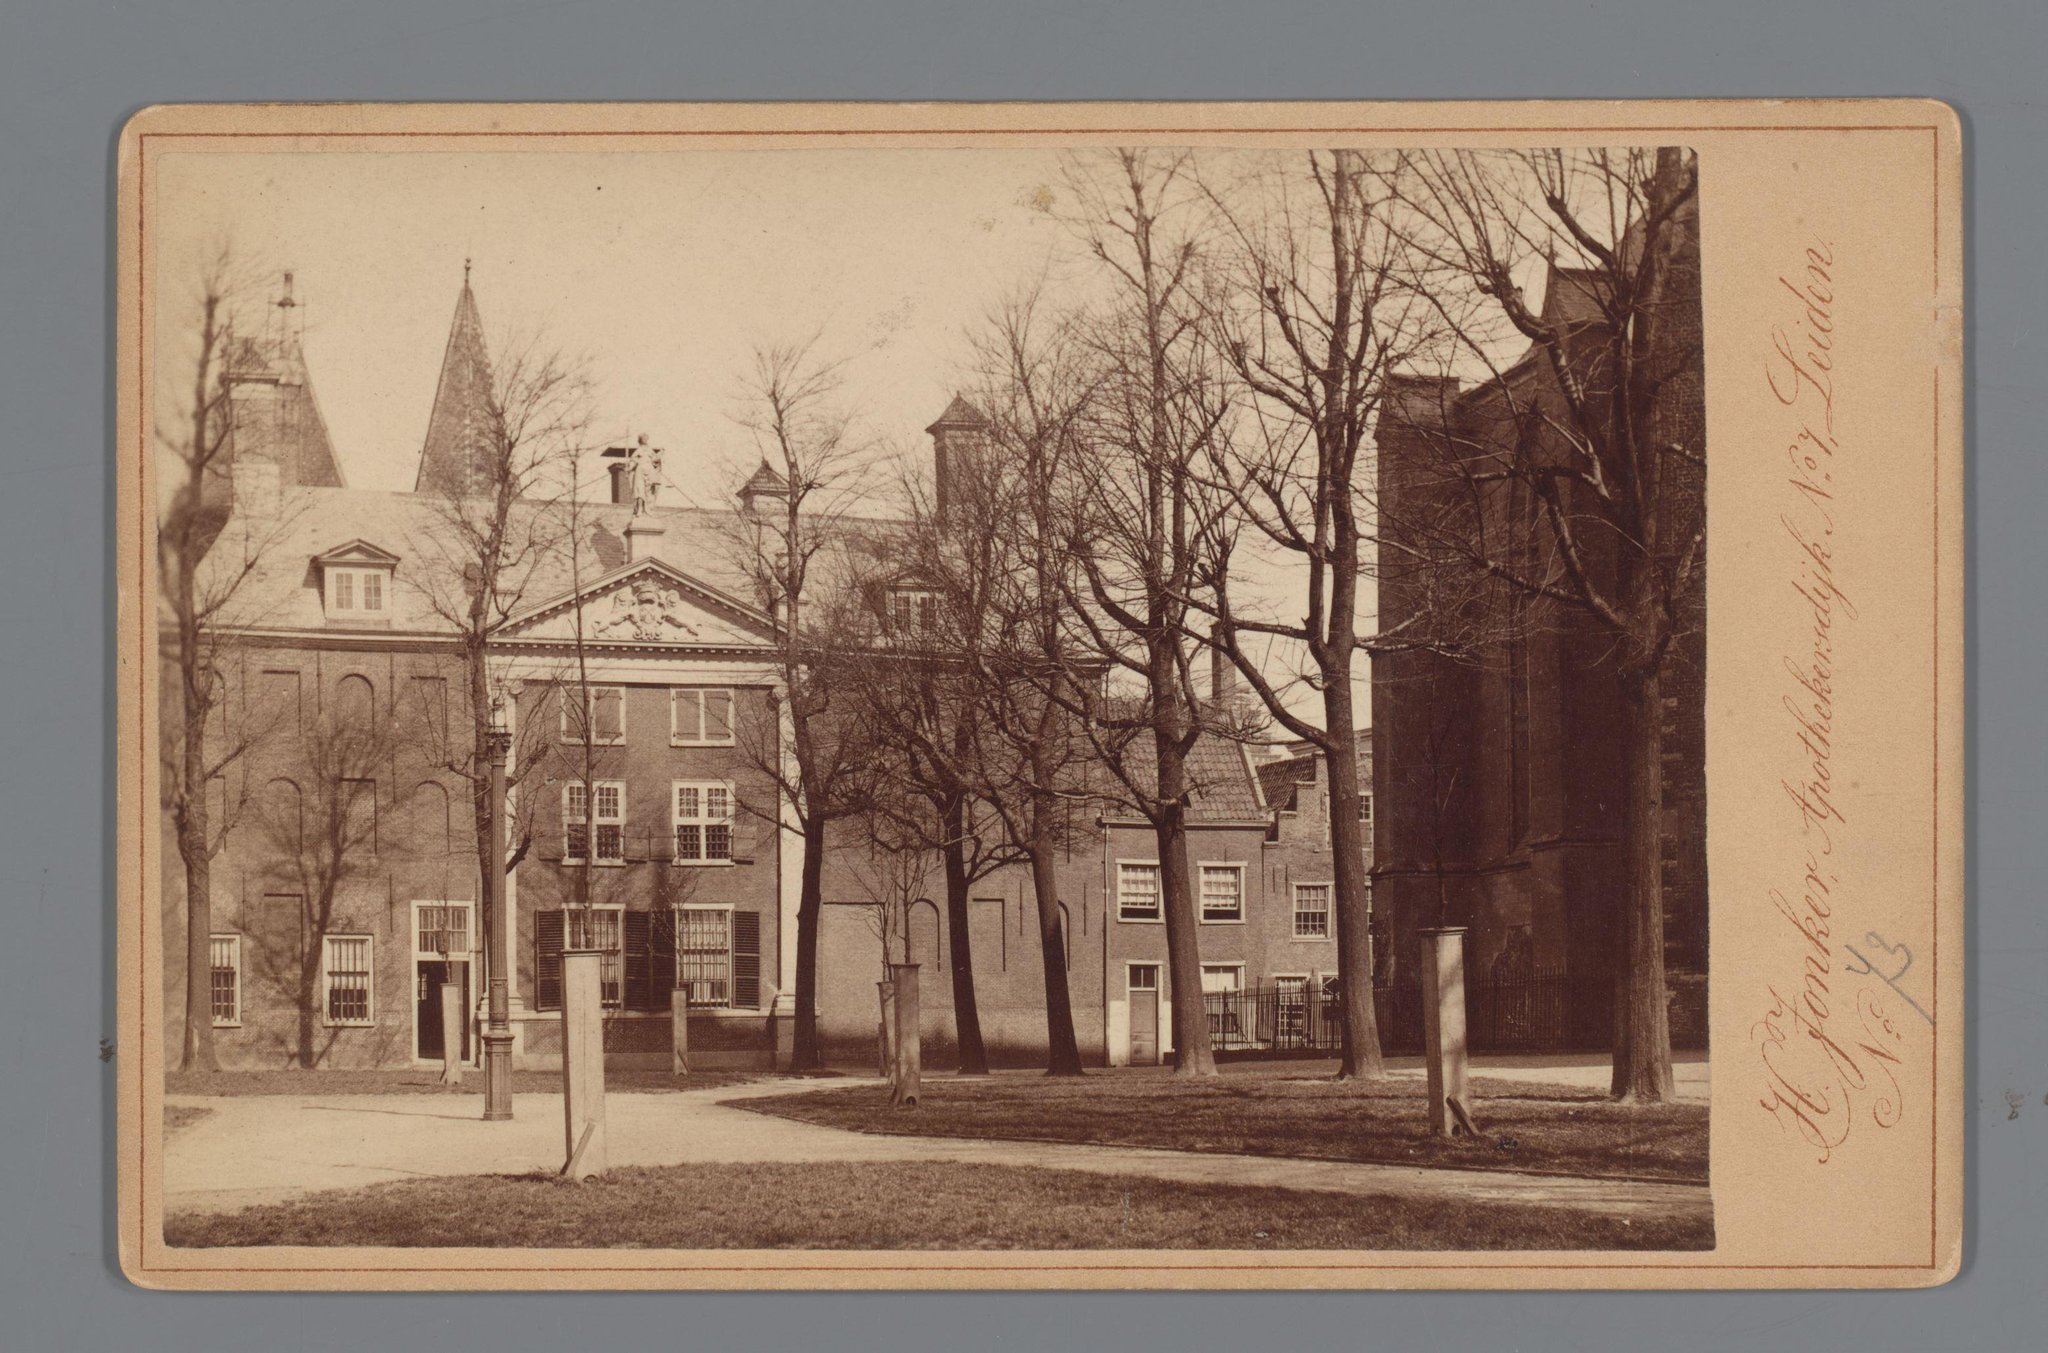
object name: photograph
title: Gezicht op het Gravensteen te Leiden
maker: hendrik jonker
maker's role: fotograaf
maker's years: 1846-1932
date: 1882-1914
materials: cardboard, photographic support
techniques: albumen print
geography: leiden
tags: façade (of house or building)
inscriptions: inscription: ‘H. Jonker, Apothekersdijk No7, Leiden/ No 73’, annotation: ‘'t Spinhuis op 't Pleintje/ 1655/ deel van Gerecht aan Pieterskerkhof’